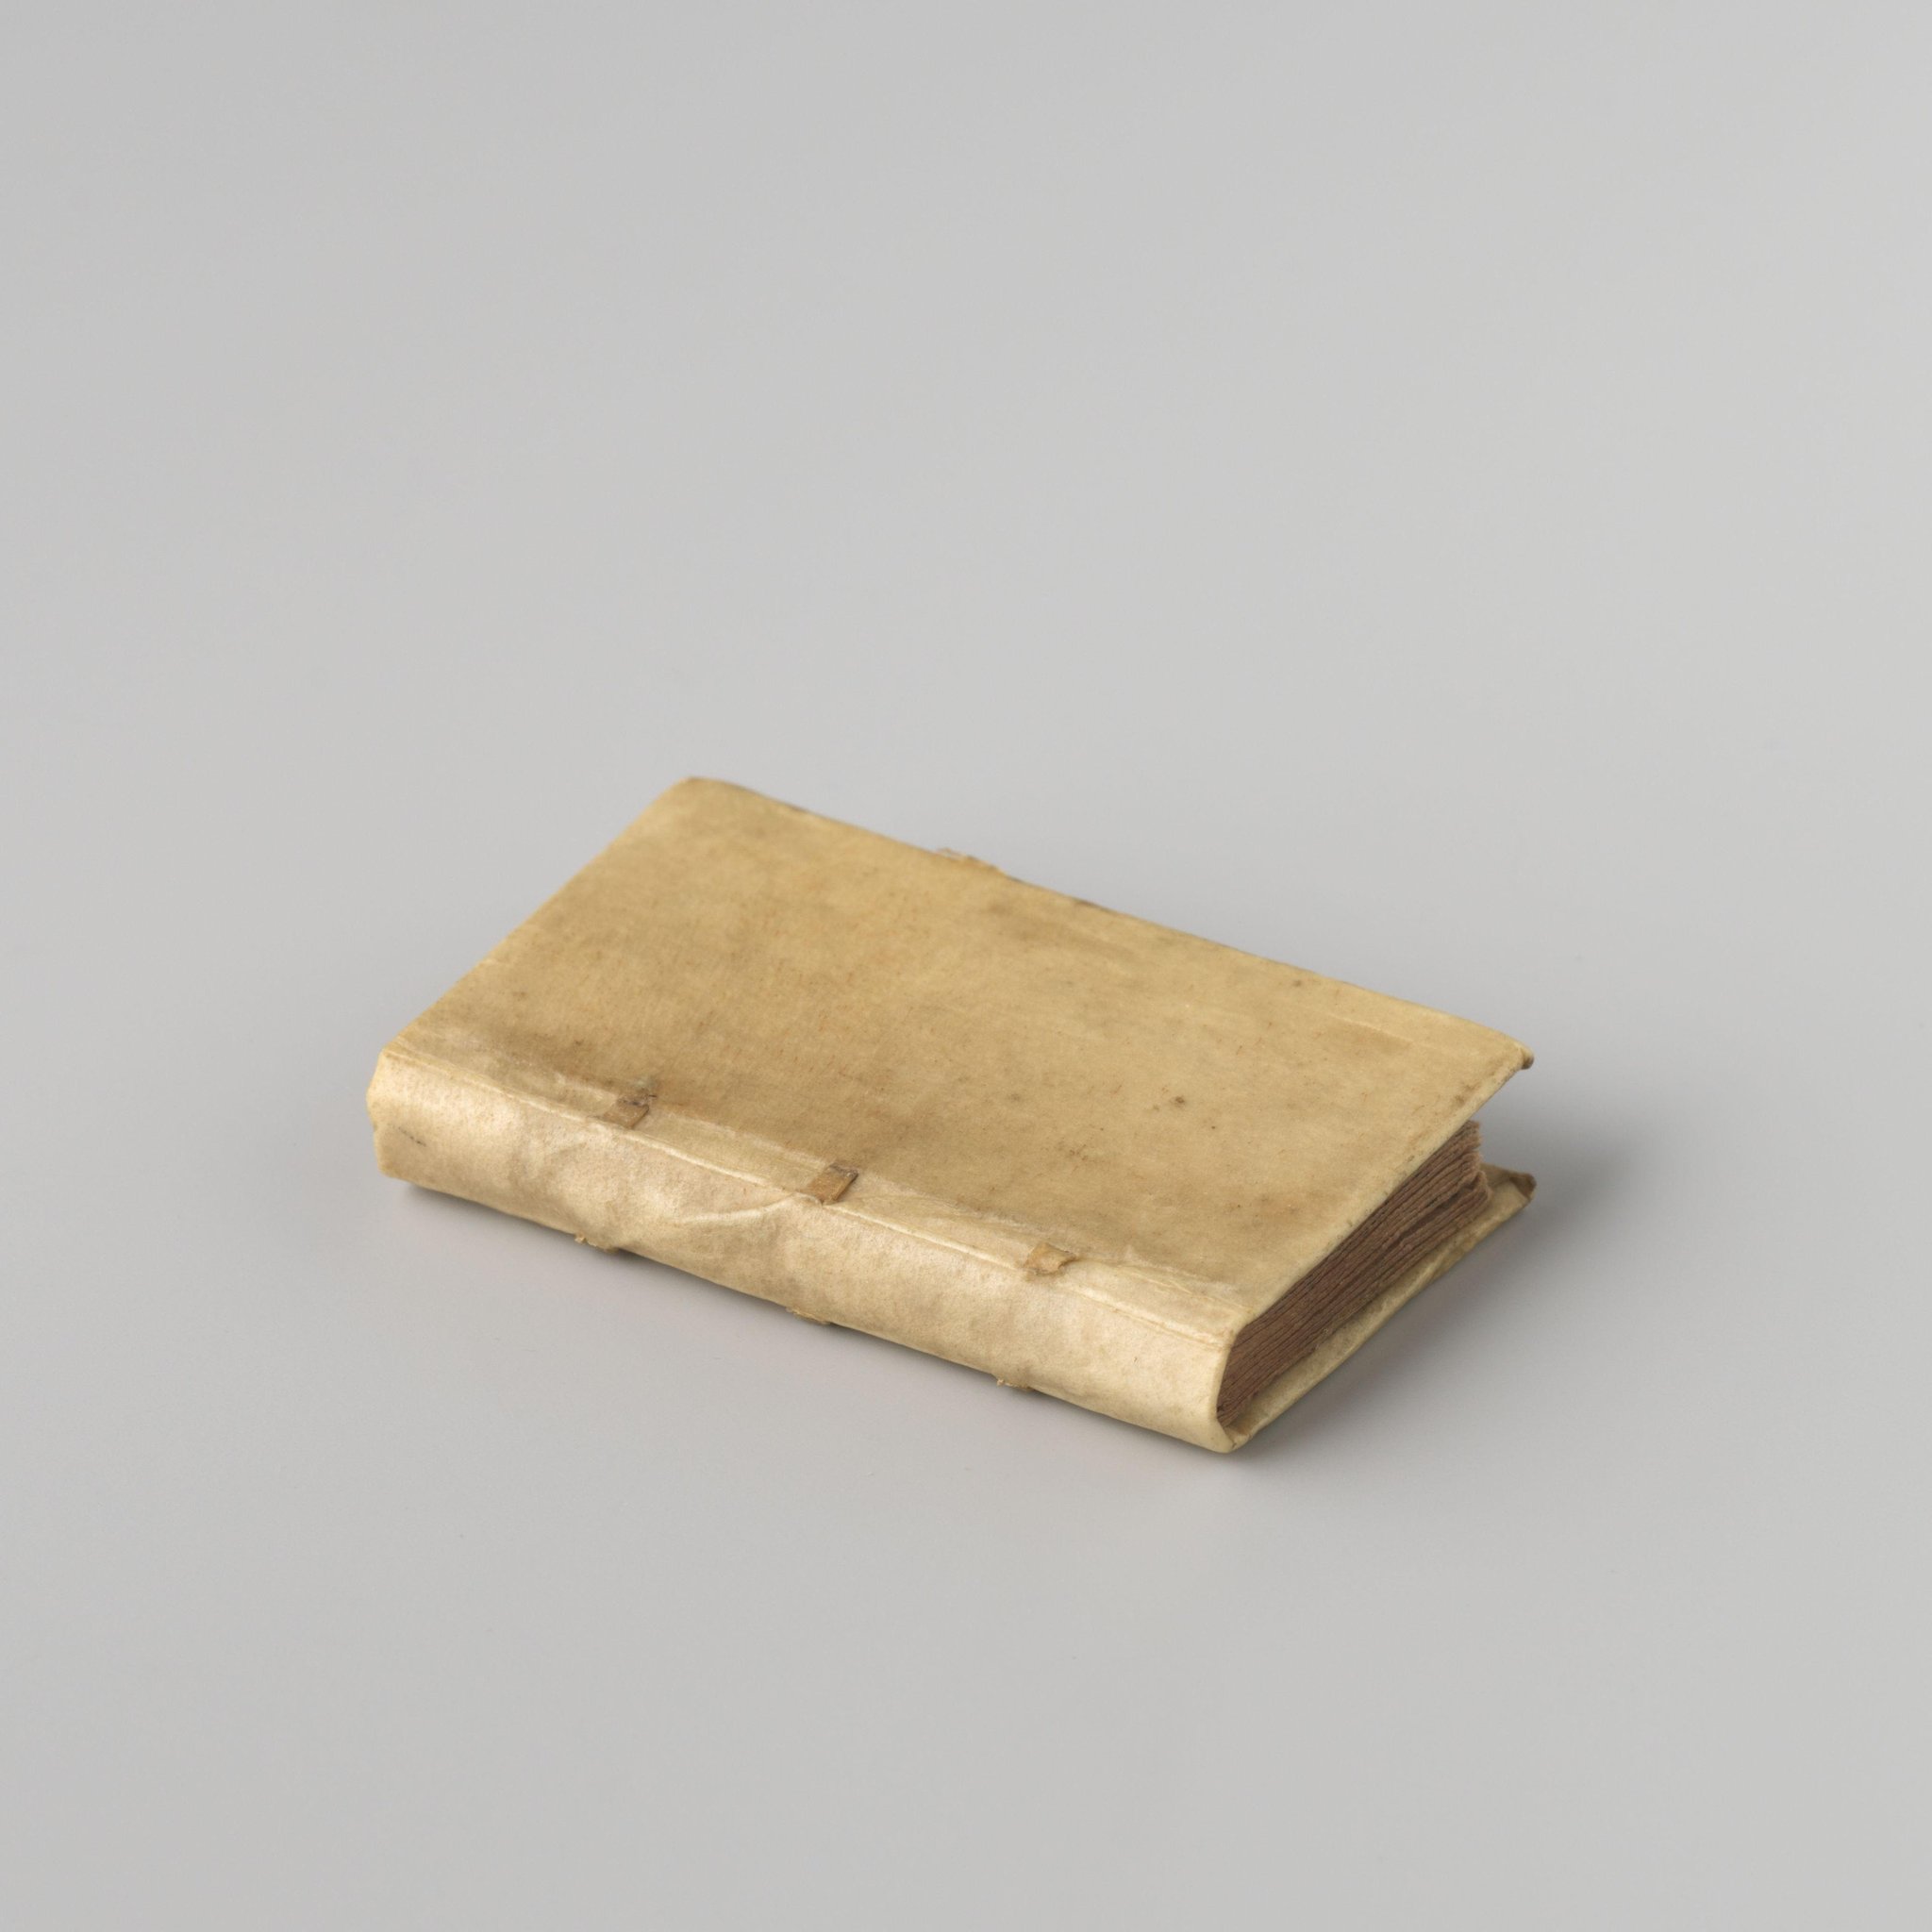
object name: miniature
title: Van de Pausen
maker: Anonymous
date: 1676-1689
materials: paper, parchment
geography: amsterdam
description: Eén van 6 boeken uit een serie van oorspronkelijk 10; gebonden in blank perkament (zg. splitel binding), hergebruikt (makulatuurr) snede, ongekleurd. 4 katernen van 4 plakstroken. De bladzijden zijn aan de plakstroken geplakt recto en verso, geknipt uit een langestrook met koppen van 25 pausen, voorafgegaan door geschreven tekst: Omnium pontigicuma S. Petro Usque an Praesentem effigies ab antiquis diligenter extractus. "Het tiende deel van de Pausen". Uitgeknipt uit een tussen 1676 en 1689 uitgegeven prent.